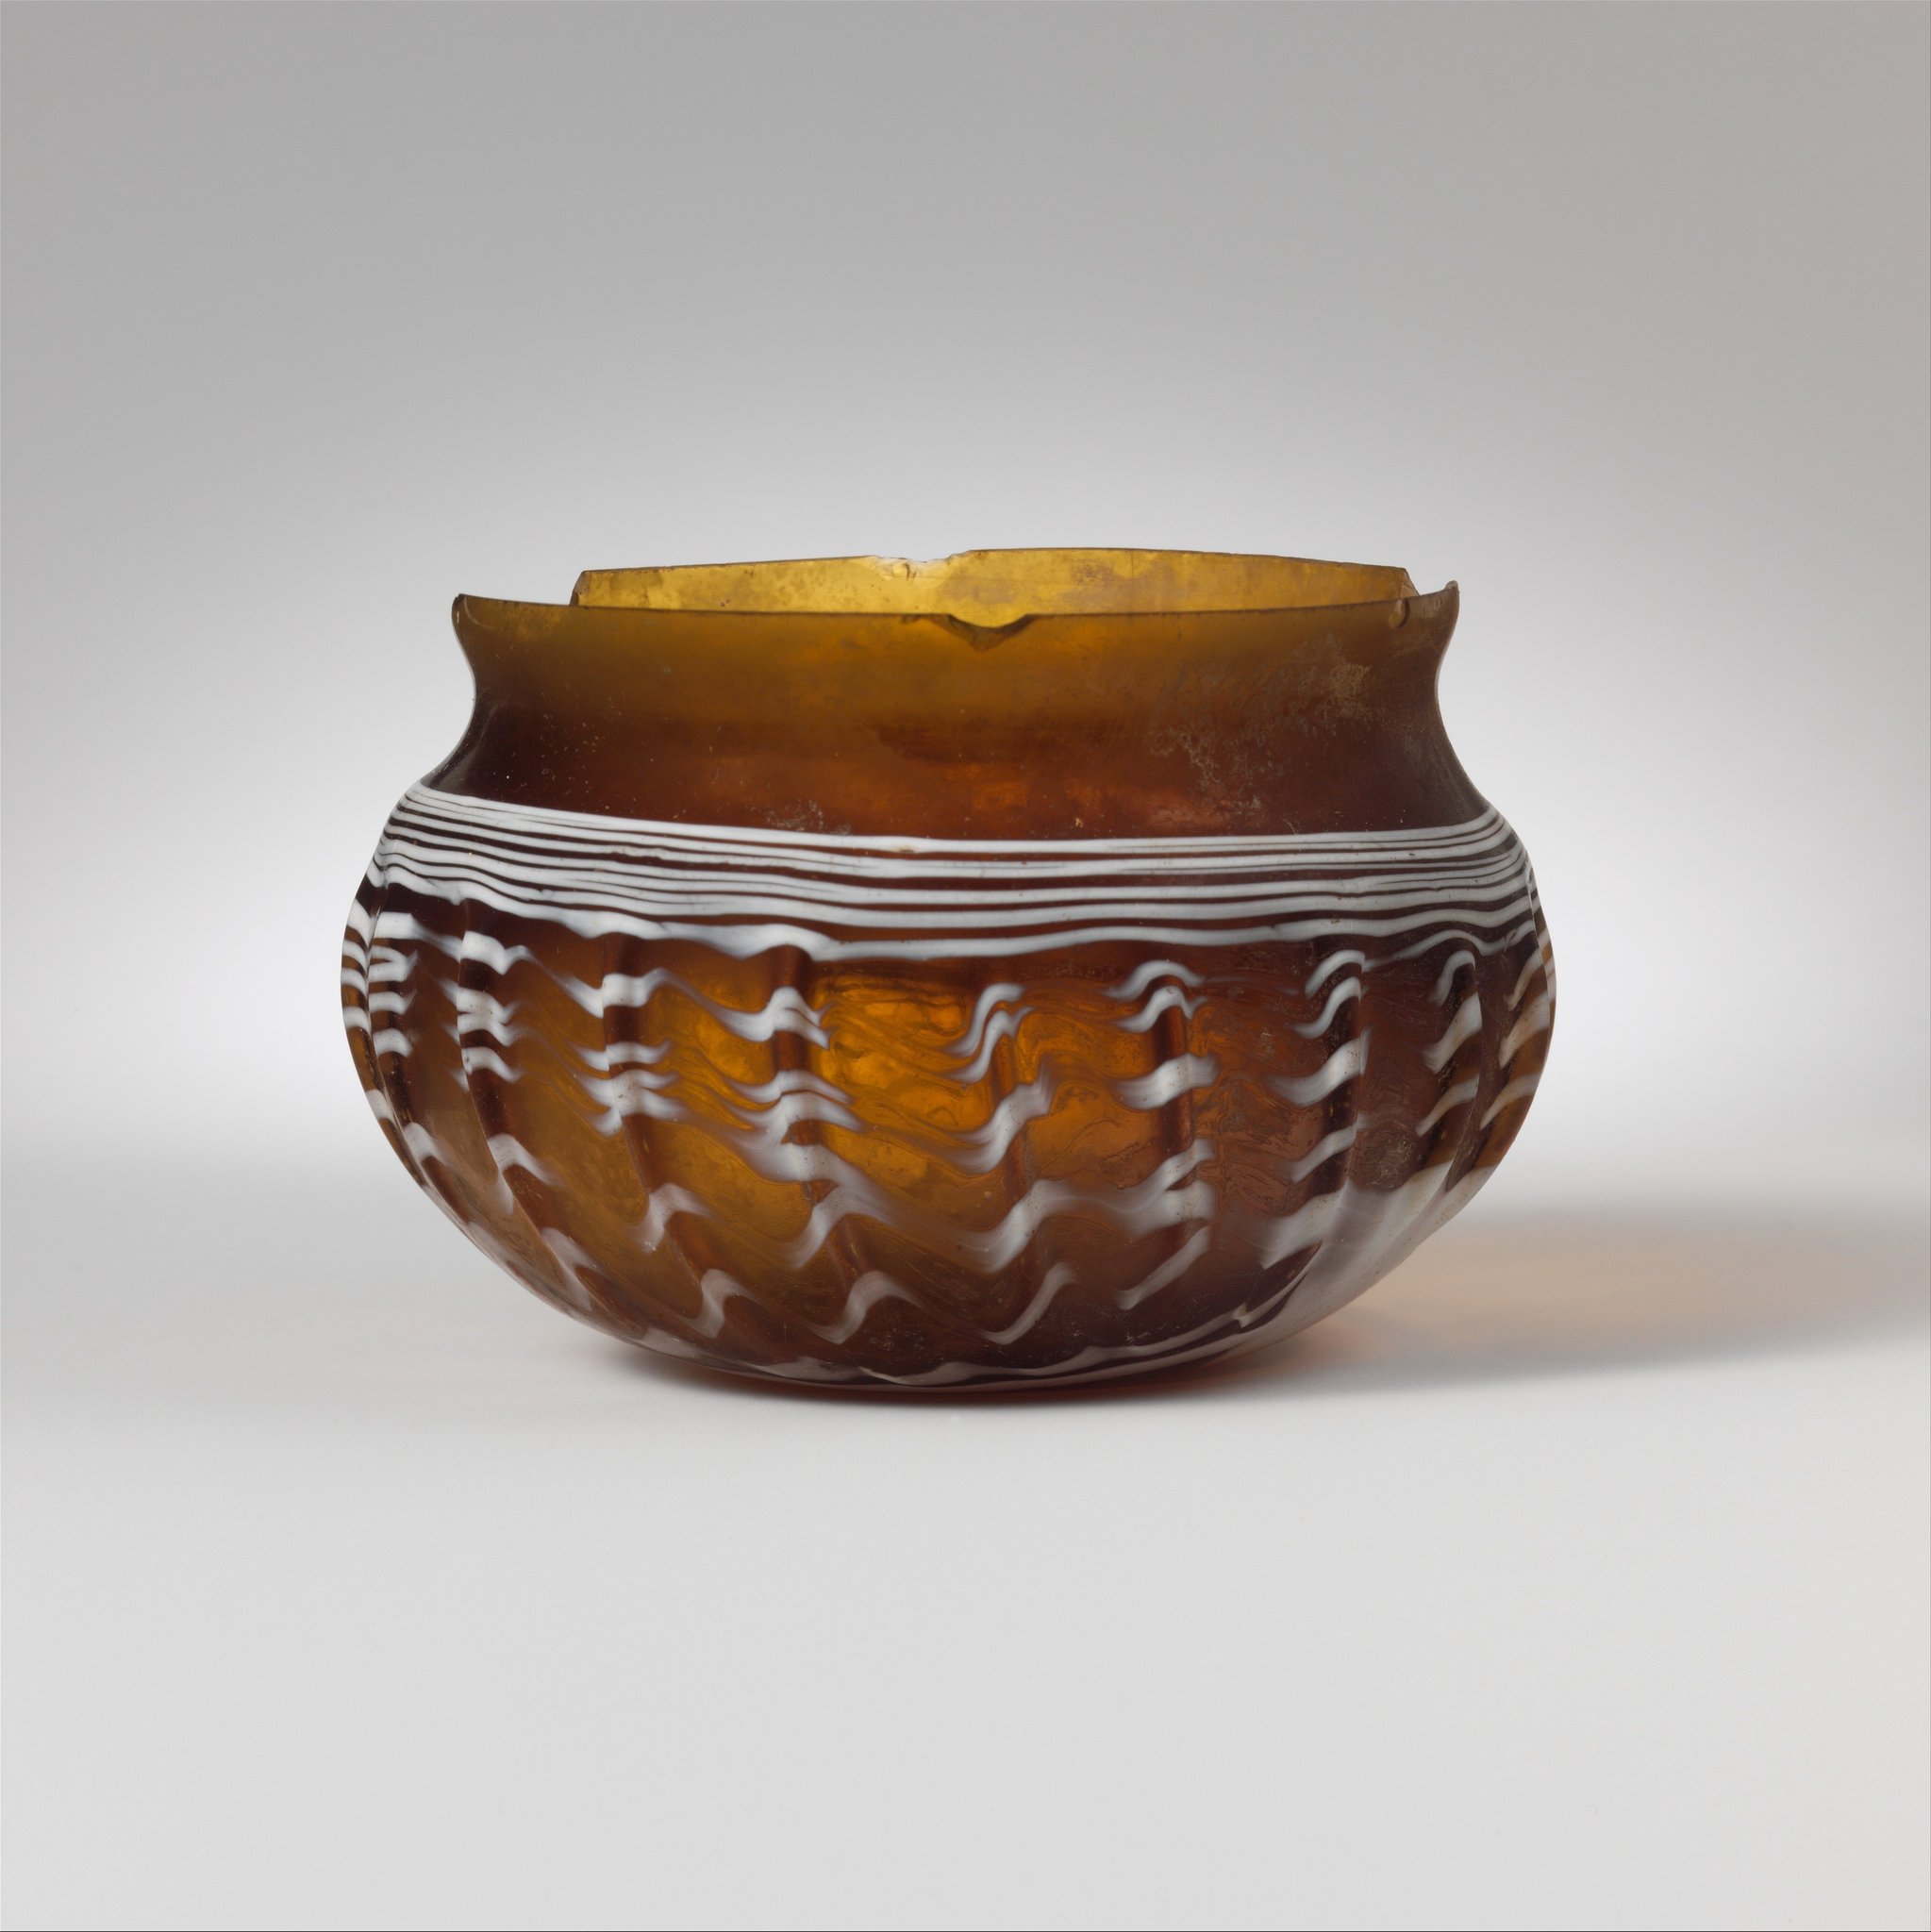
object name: bowl, rippenschale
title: Glass ribbed bowl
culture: roman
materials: glass